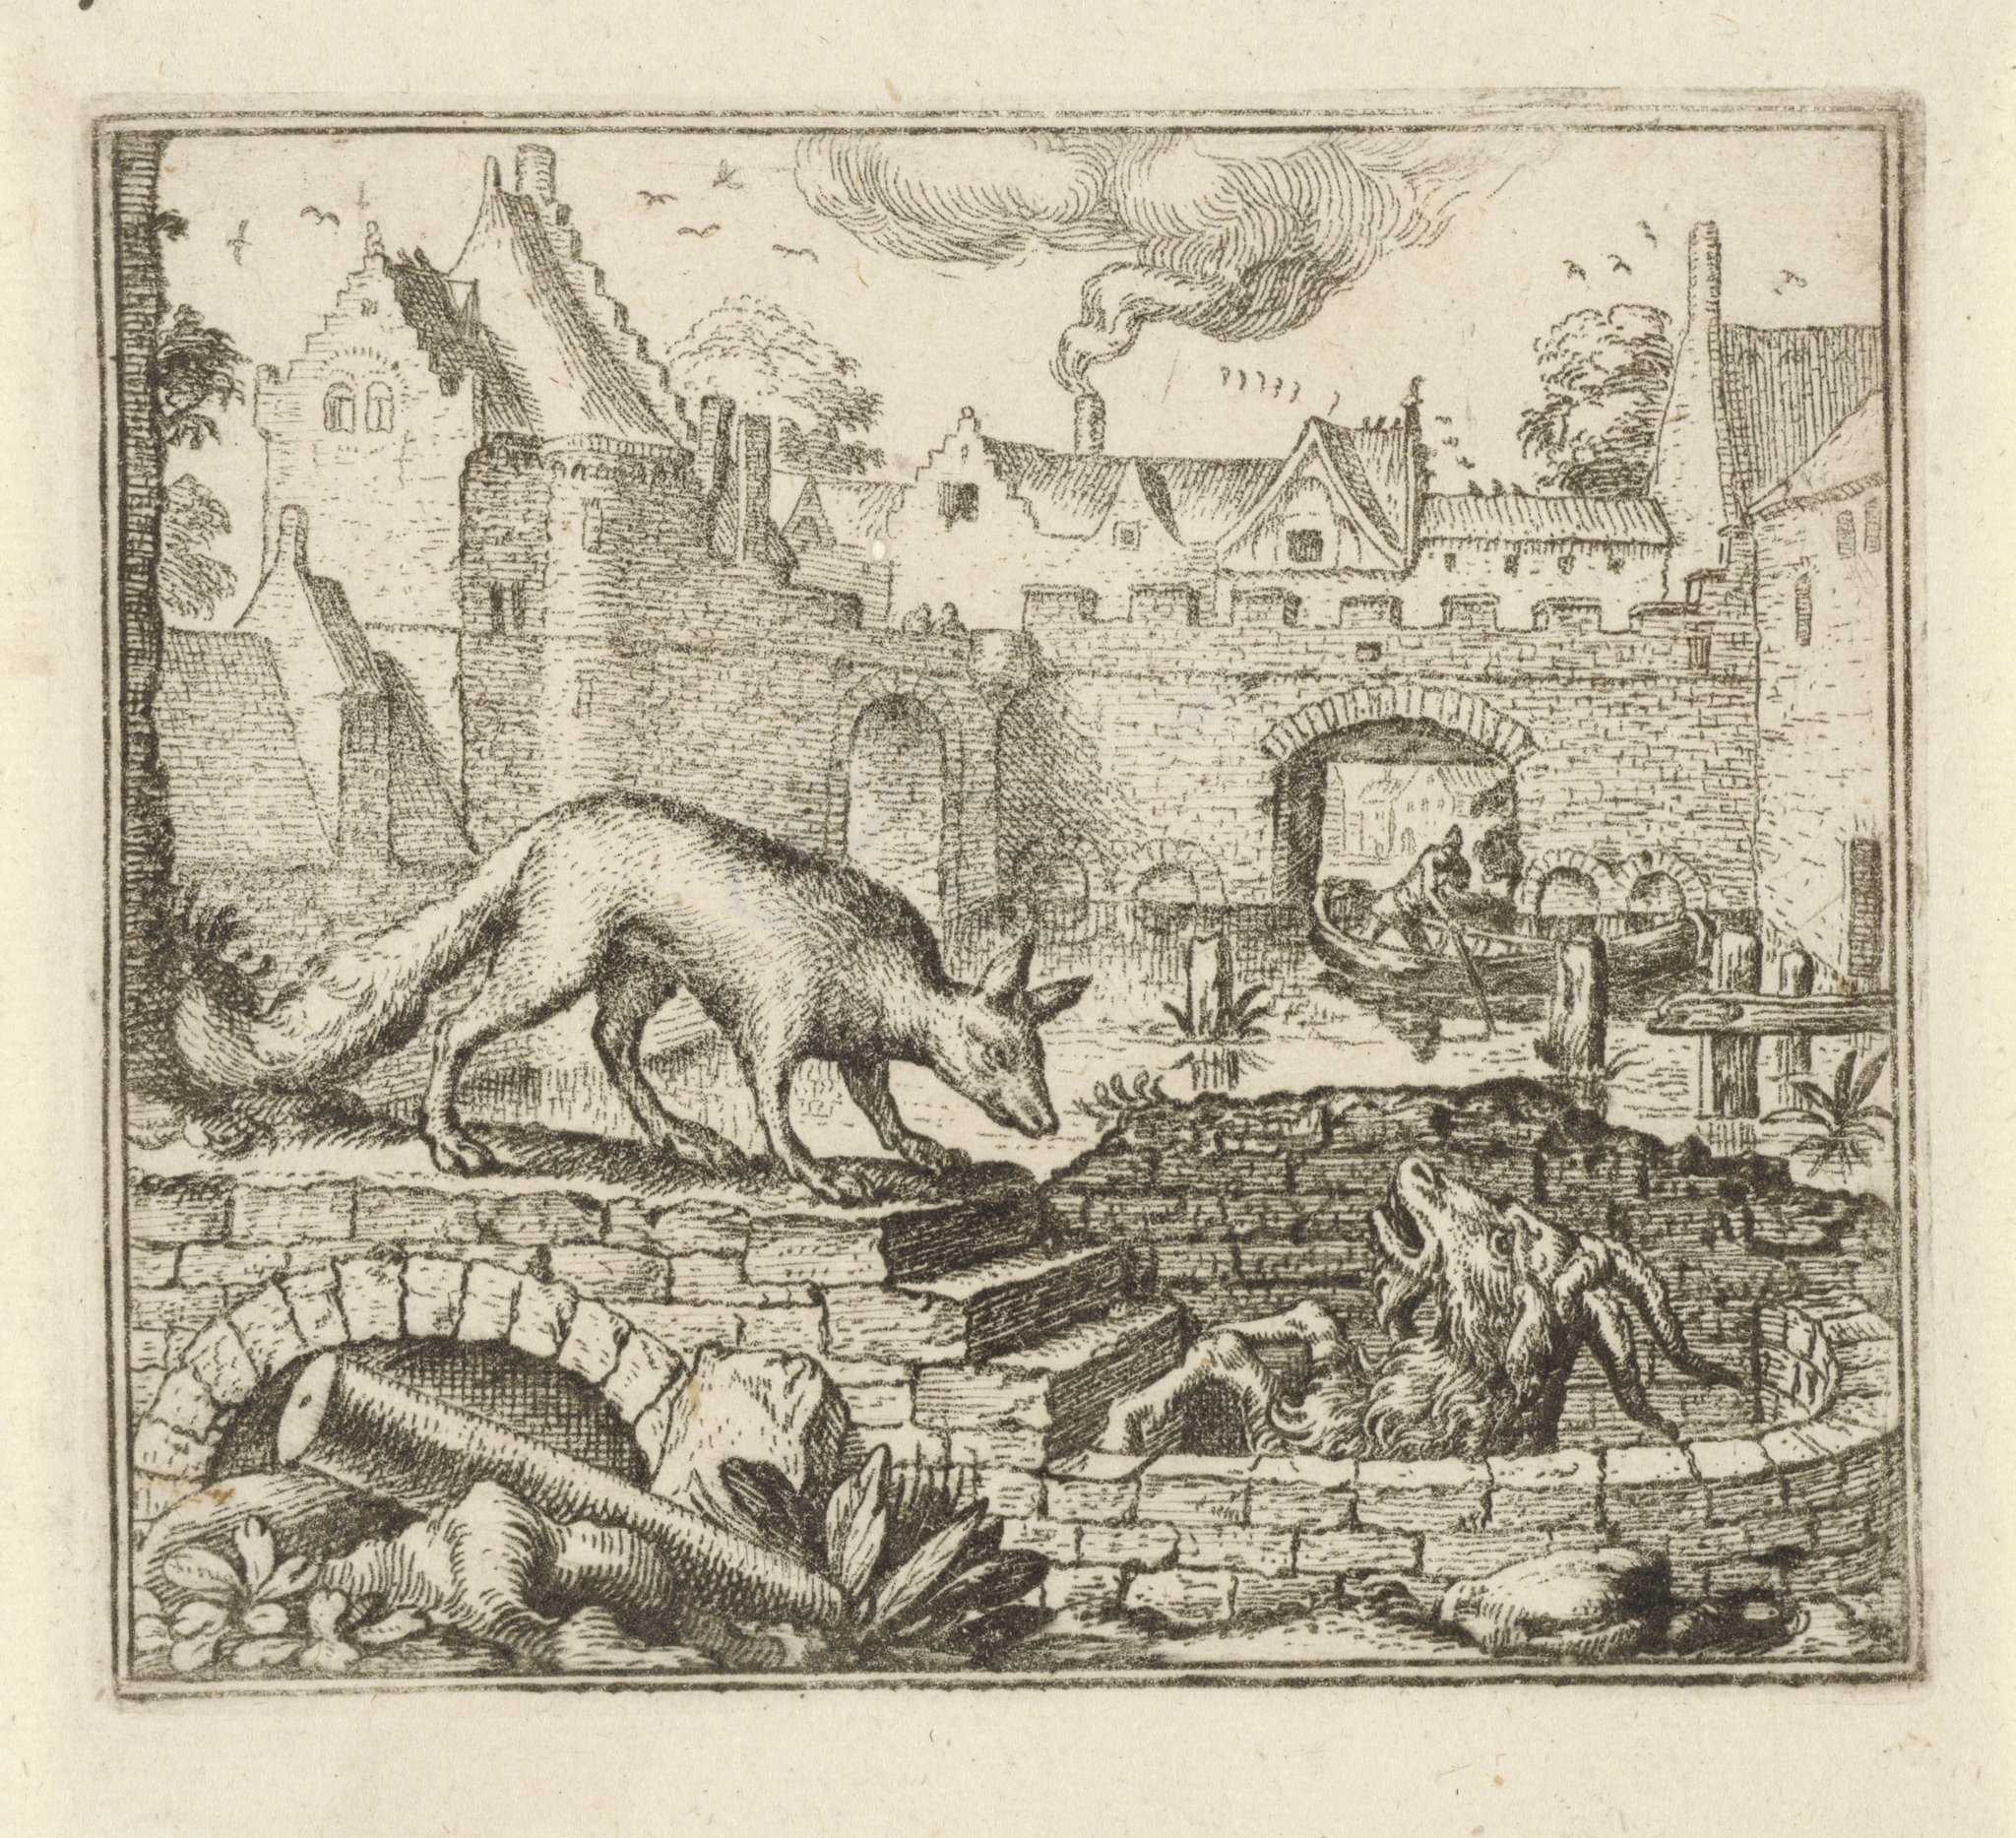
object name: print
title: Fabel van de vos en de geit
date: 1608-1679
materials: paper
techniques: etching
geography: prague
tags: fables, goat, beasts of prey, predatory animals: fox, cellar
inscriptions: collector's mark: Lugt 2228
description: De vos staat boven een keldertrap. De geit zit in de kelder. Op de achtergrond een stad. De fabel beschrijft hoe de vos samen met een geit een kelder binnenbreken om daar wijn te drinken. De geit helpt de vos de kelder opnieuw te verlaten, maar kan er zonder hulp zelf niet uit. Het verhaal waarschuwt voor edelmoedig handelen.